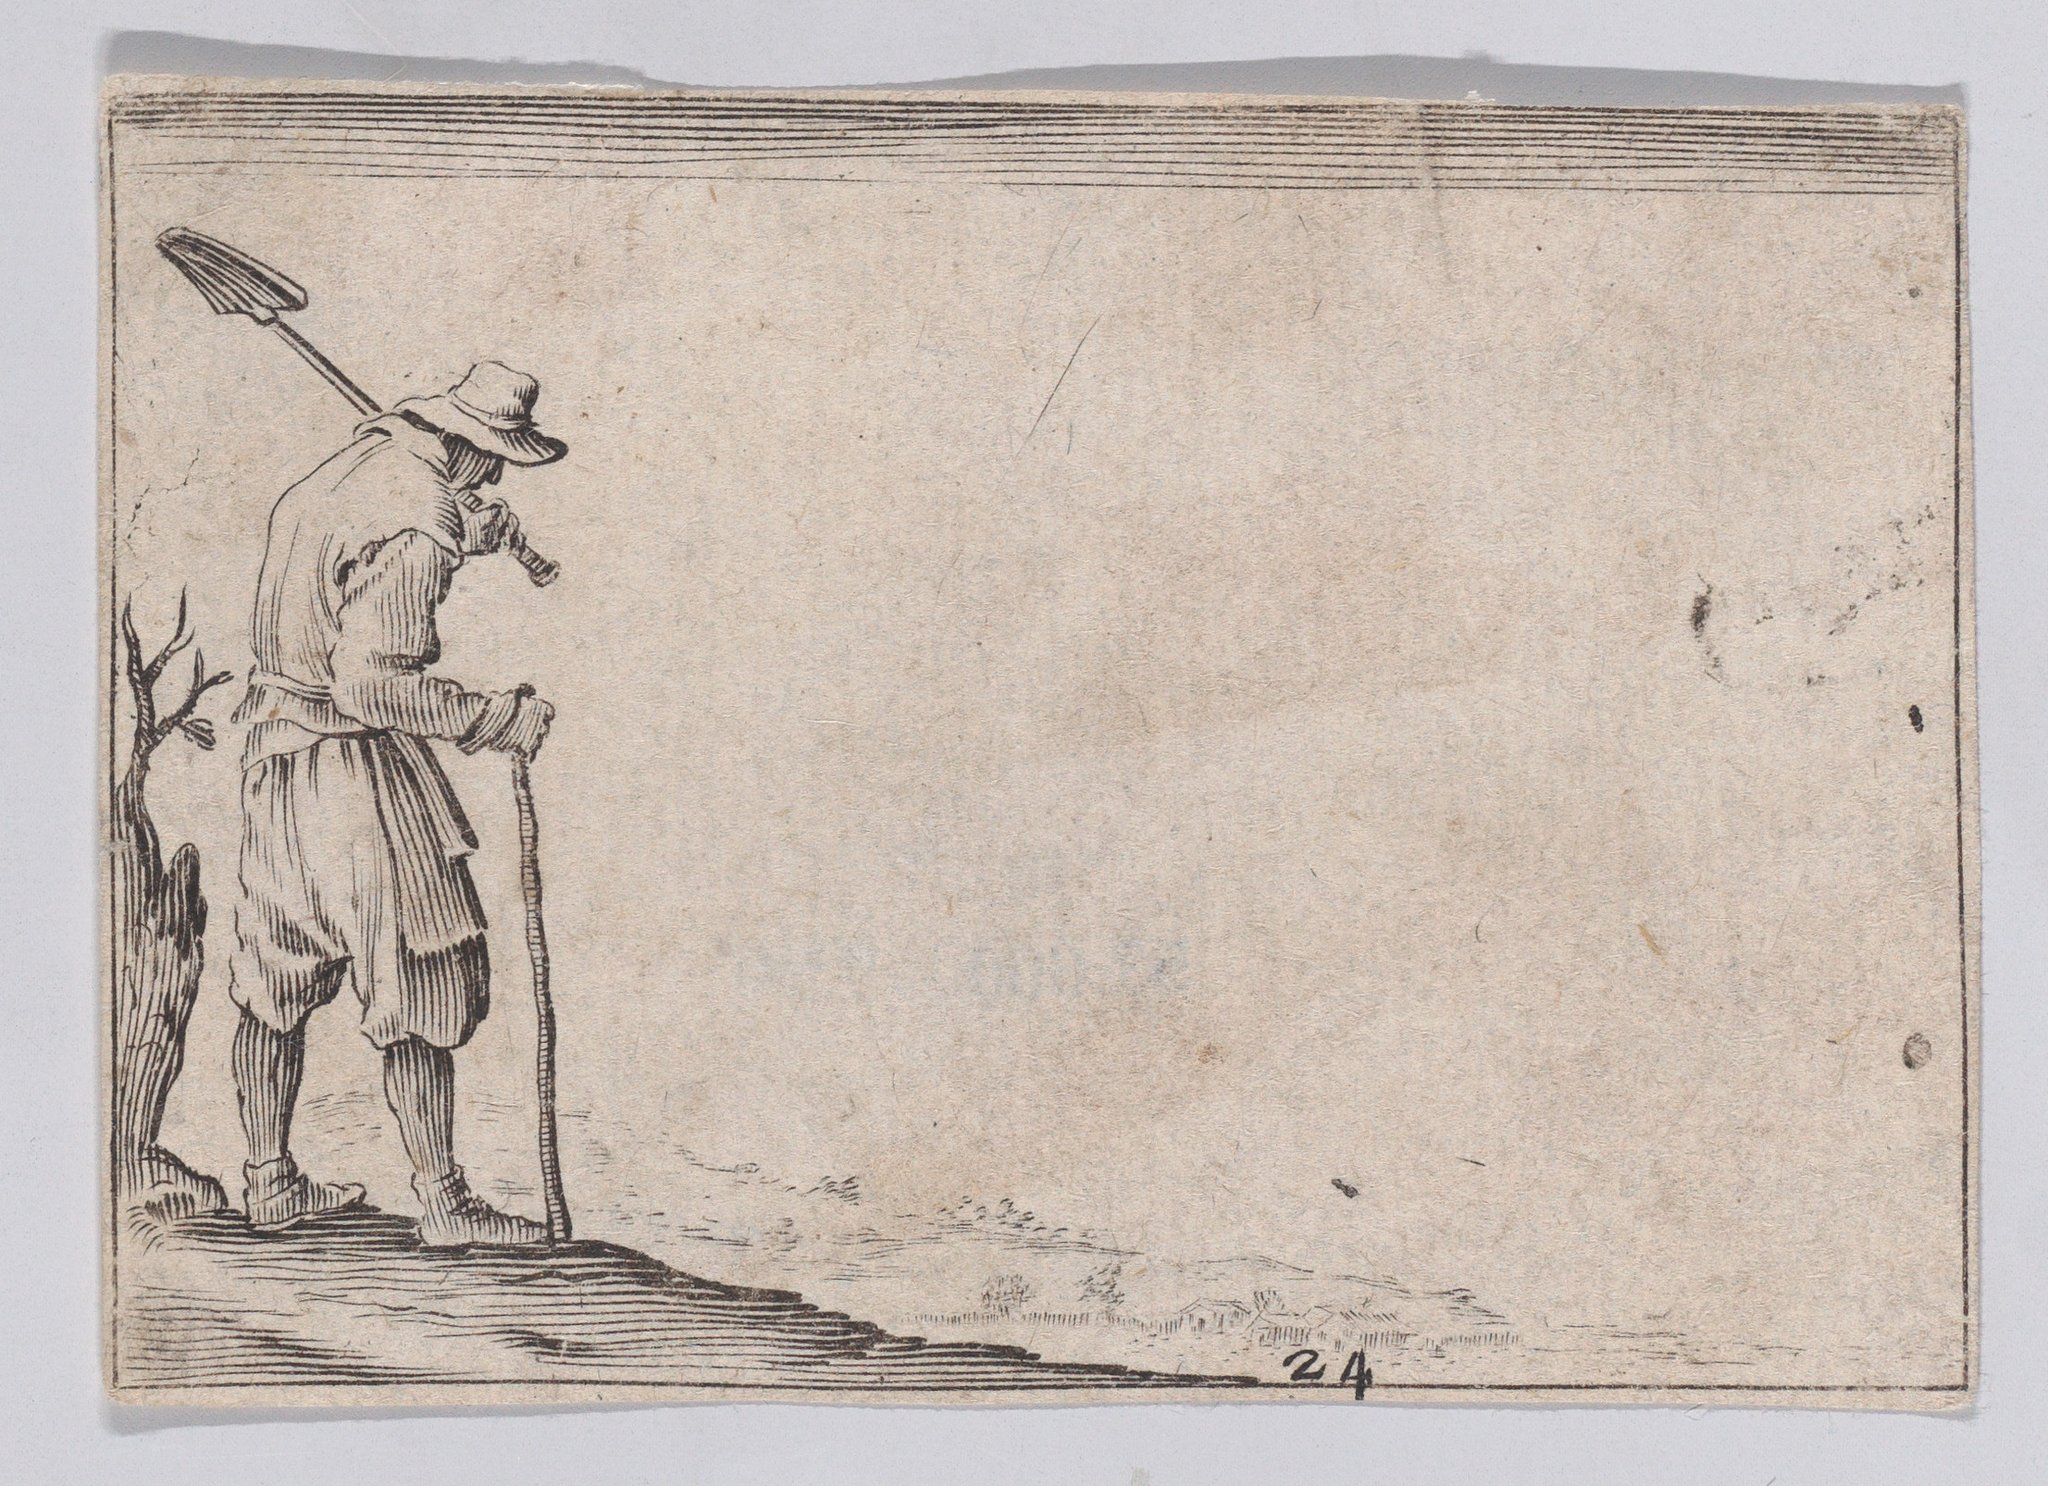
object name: print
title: Reverse Copy of Le Paysan Portant sa Pelle sur L'Épaule (The Peasant Carrying his Shovel over his Shoulder), from Les Caprices Series A, The Florence Set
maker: Anonymous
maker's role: artist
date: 1601-1700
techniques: etching